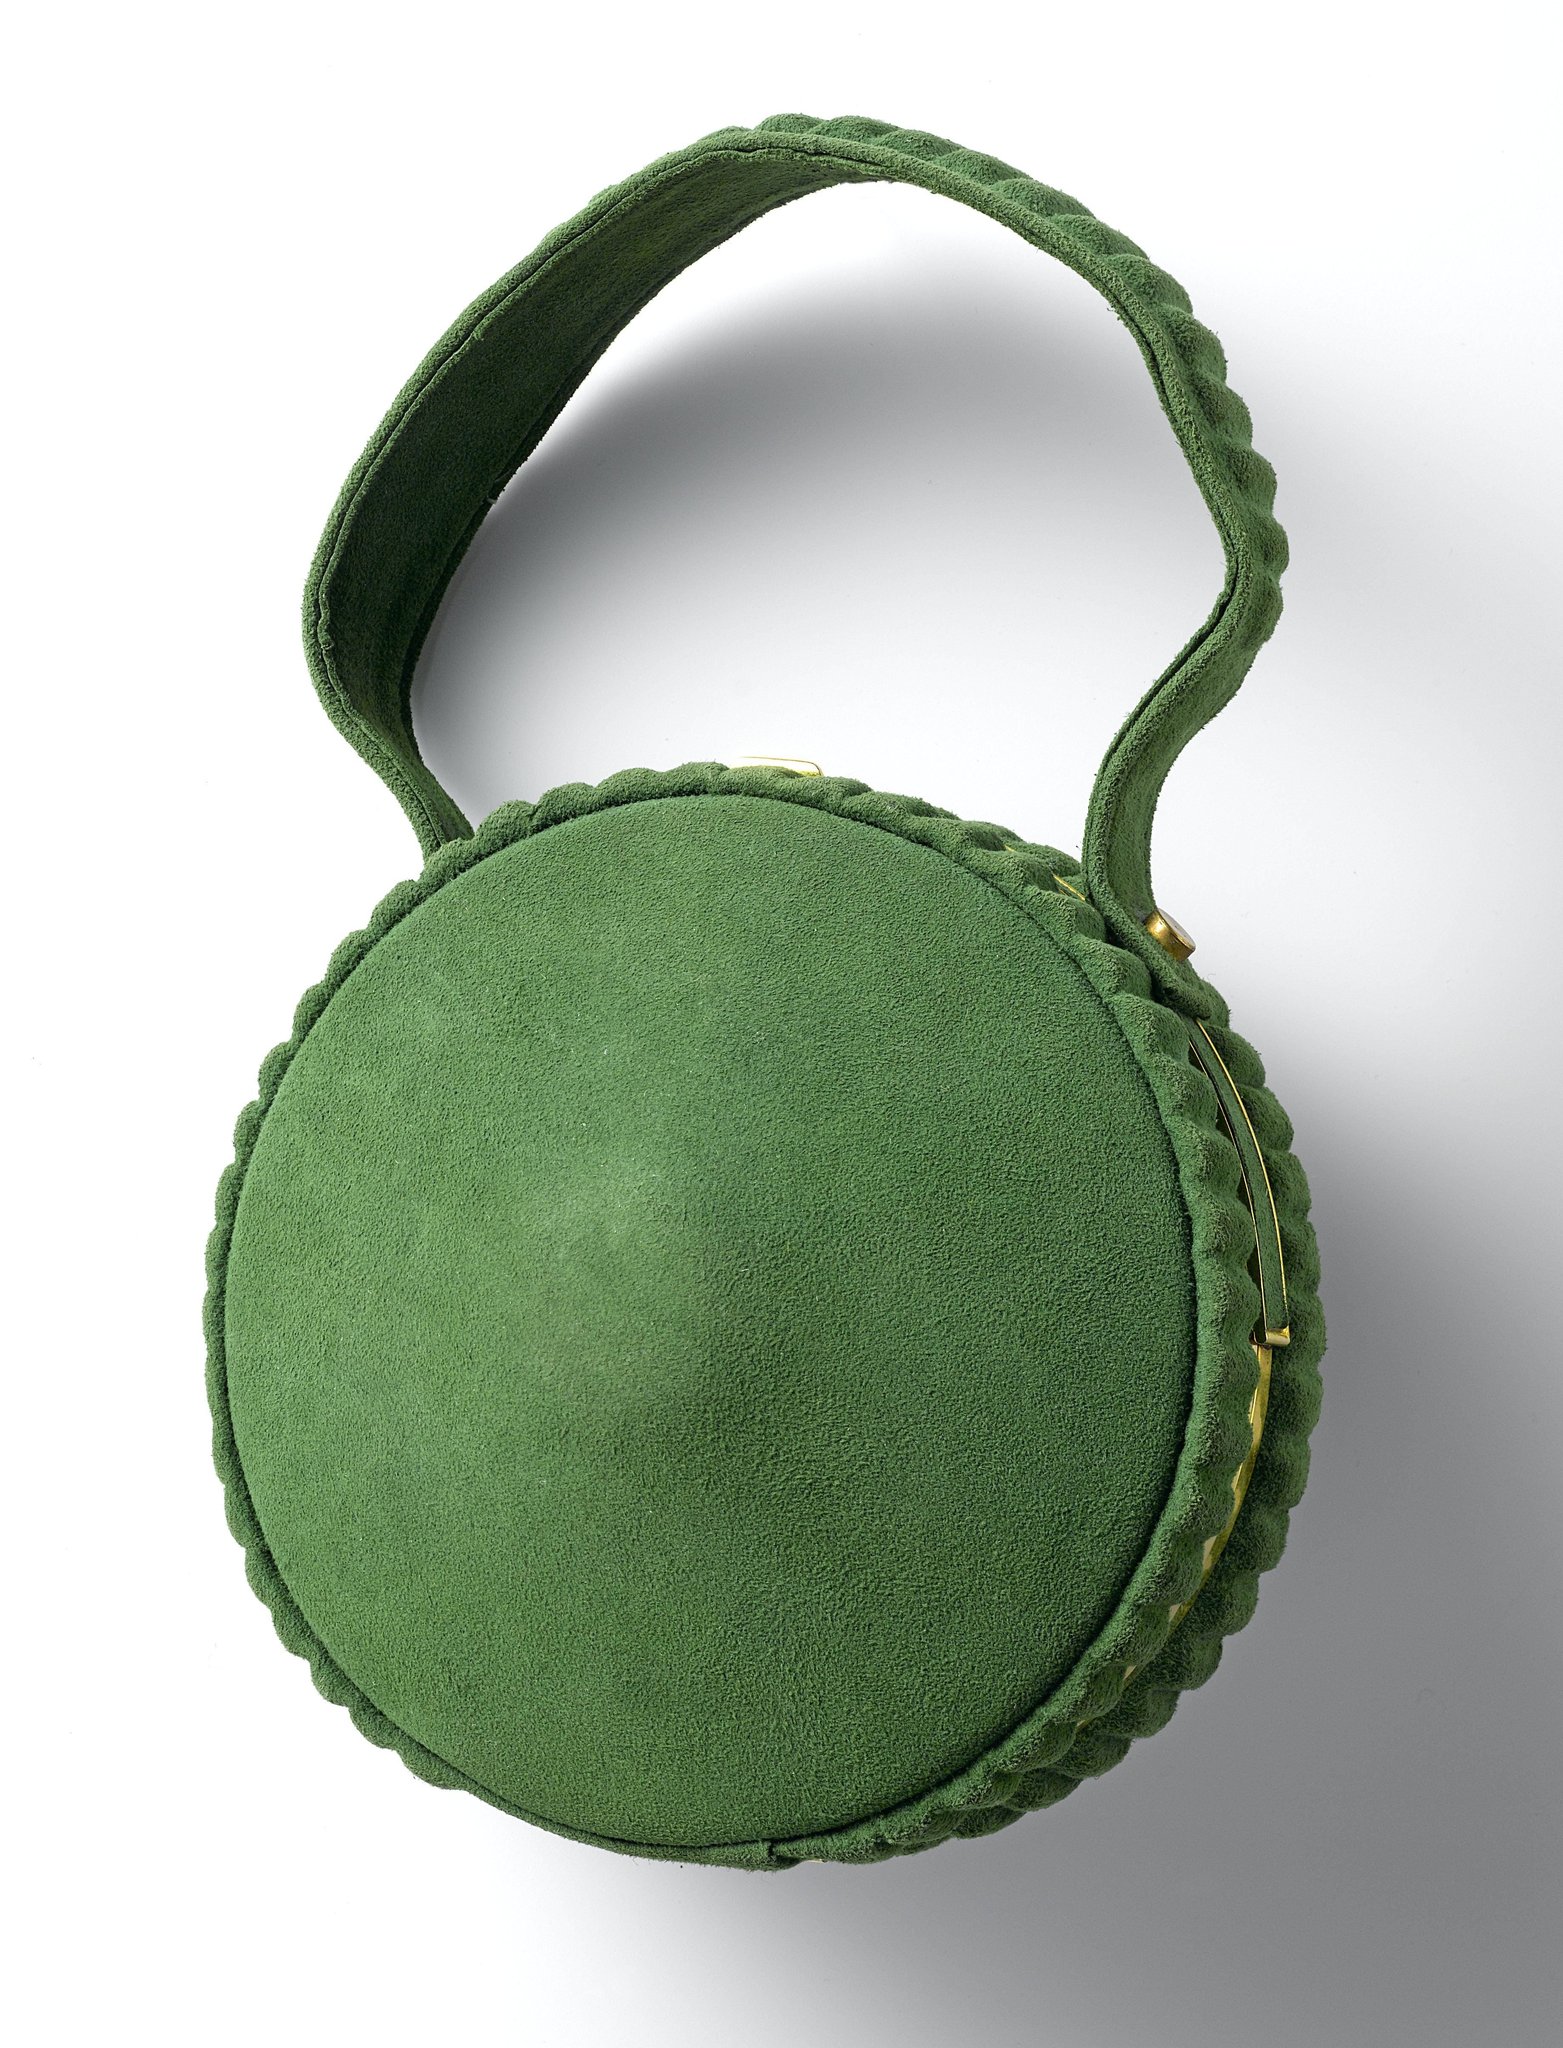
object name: handbag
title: Ronde handtas van grasgroene peau de suède met koperen ring en sluiting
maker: Anonymous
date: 1947-1948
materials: copper, textile, leather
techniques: forging, painting, tanning, weave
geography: england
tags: amsterdam, england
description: Ronde tas van grasgroene peau de suède met koperen ring en sluiting. Model: de tas is opgebouwd uit twee identieke ronde, naar een punt in het midden oplopende helften met een hard (kunststof?) binnenwerk. Beide helften zijn afgewerkt met een koperen rand, die middenonder scharniert en middenboven sluit door middel van een plaat met een rond gat en een bolvormige knop. Het handvat is aan een helft bevestigd met twee pinnen. Gevoerd met zwarte kunstzijde. Beide helften zijn verbonden door flappen van zwarte voeringstof afgezet met een strook suède. Versiering: boven op het handvat en langs de zijkanten van de tashelften is een opgevulde, gegolfde rand aangebracht.